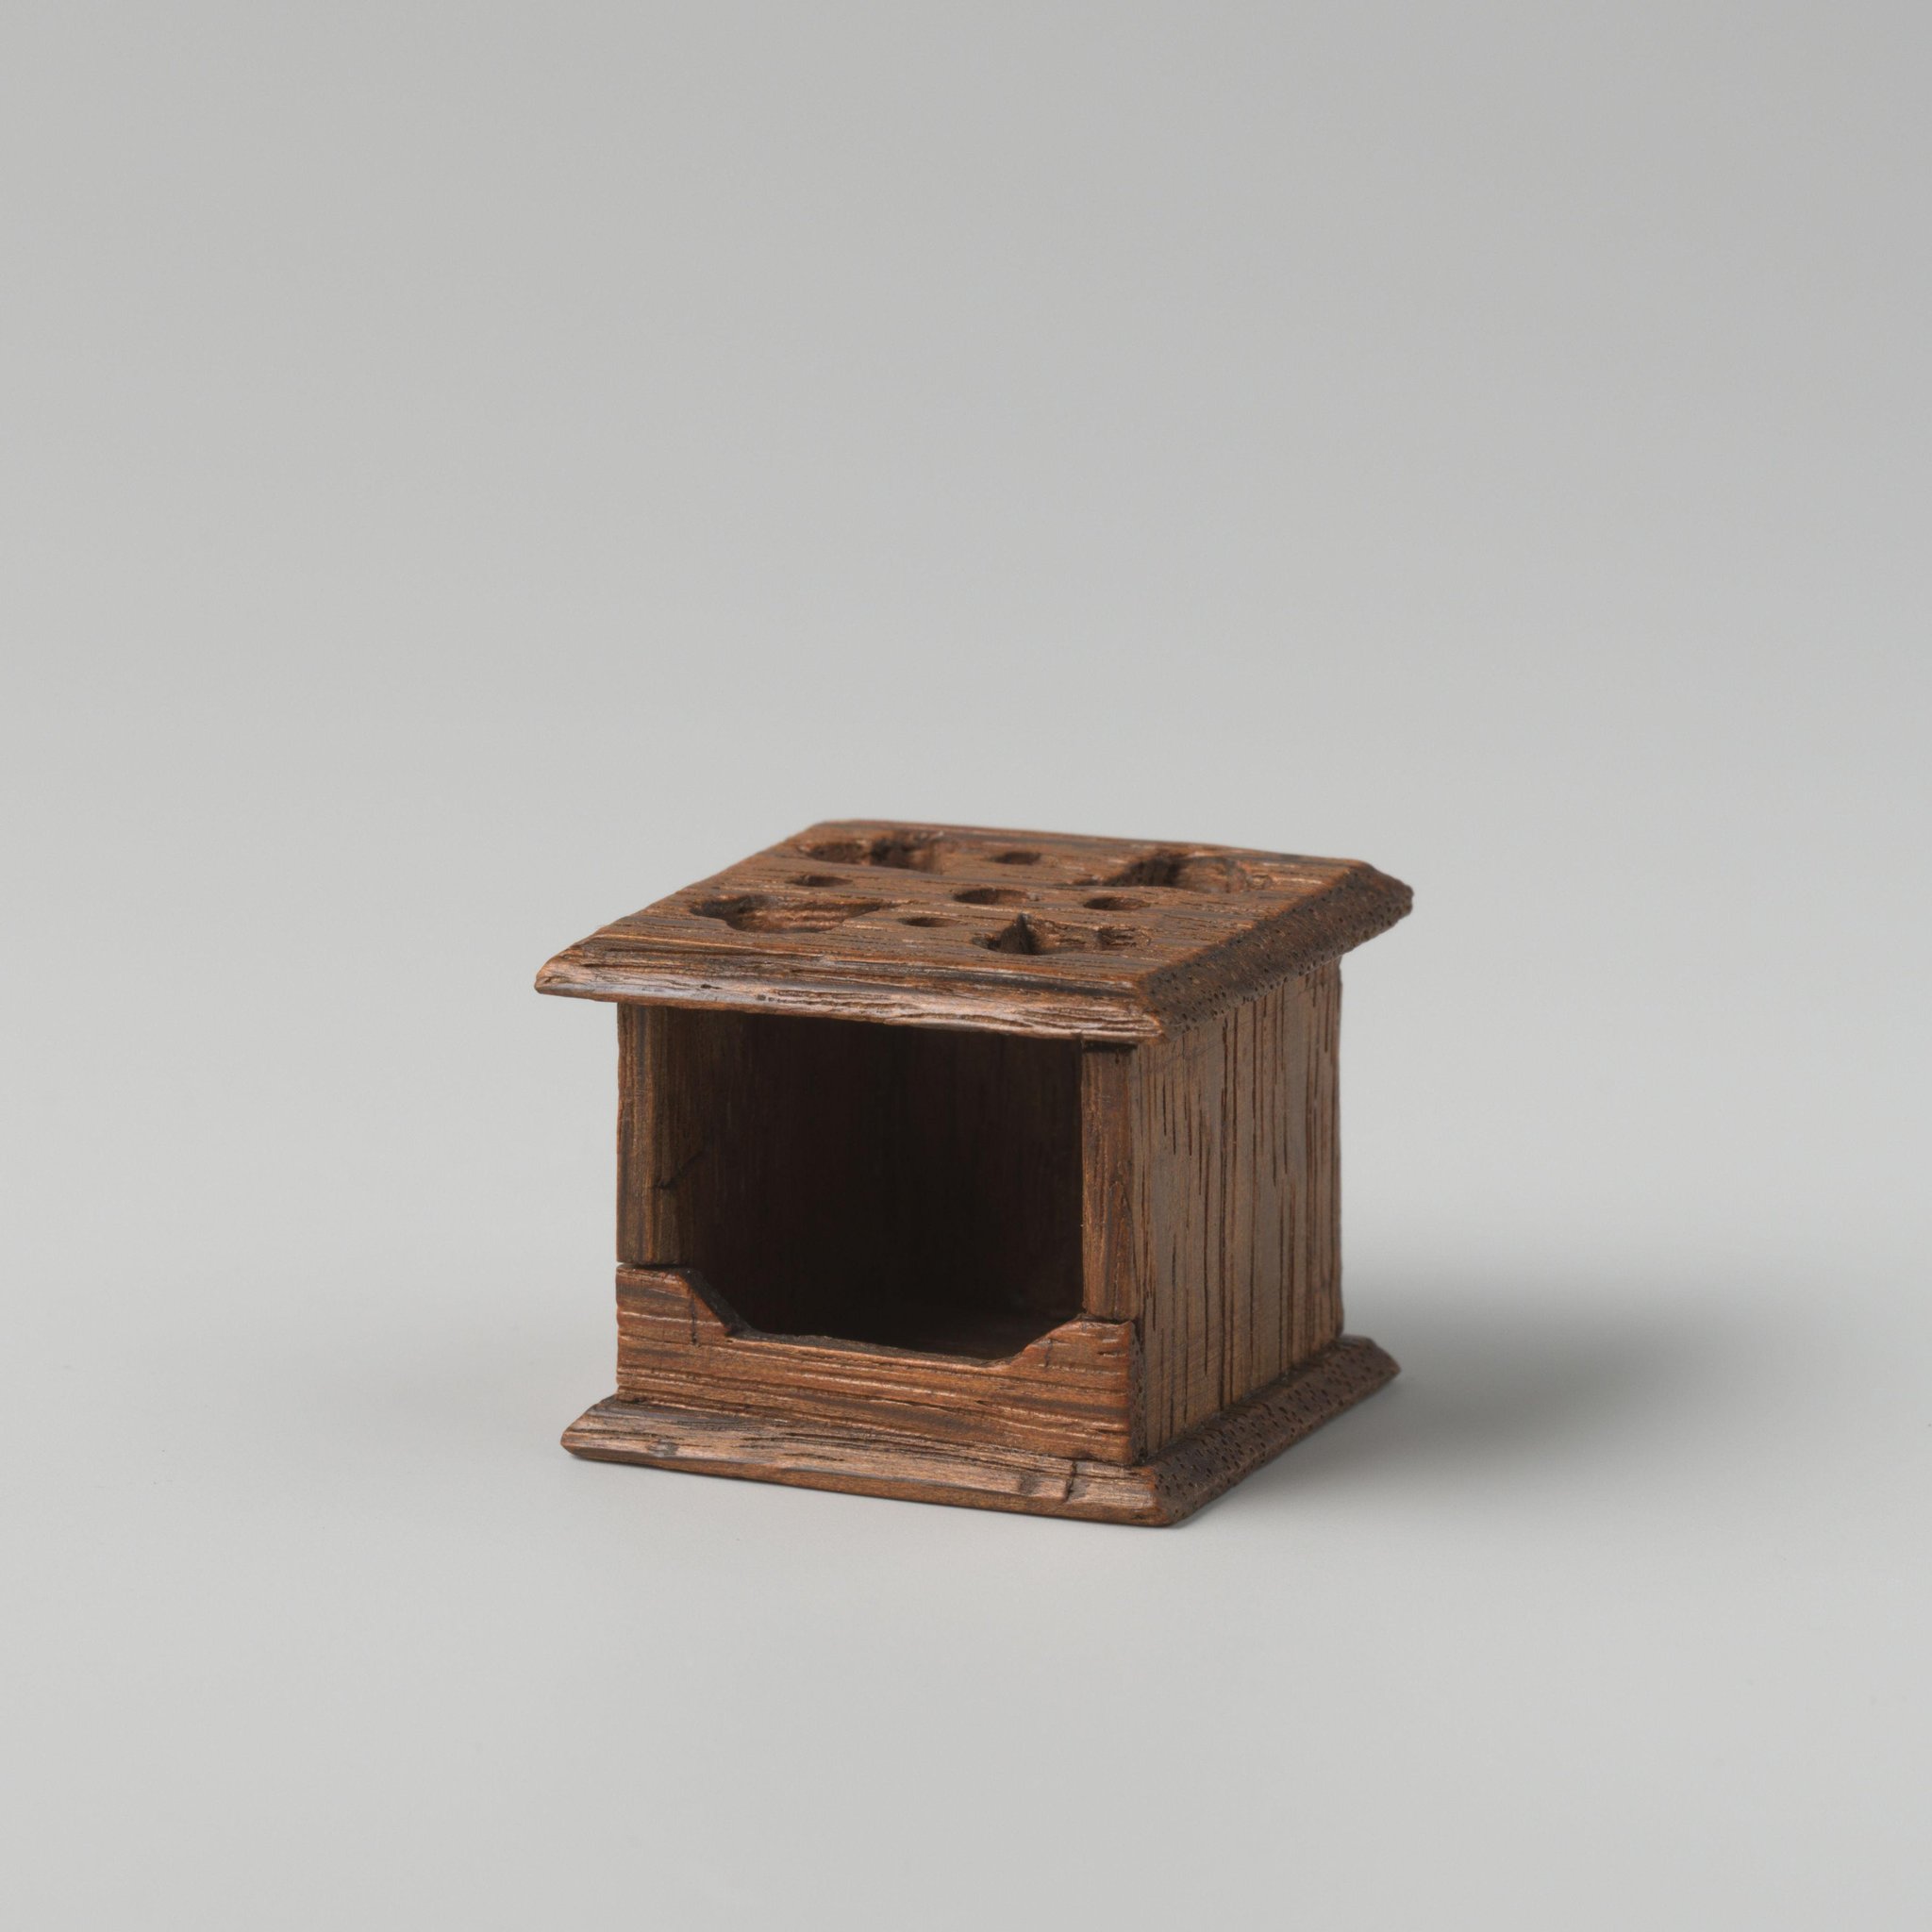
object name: miniature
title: Vierkante stoof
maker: Anonymous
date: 1690-1710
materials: wood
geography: amsterdam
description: Vierkante stoof van eikenhout. De stoof heeft een opstaande rand aan de voorzijde en in de voetenplank zijn vier hartvormige en vijf ronde gaten aangebracht.